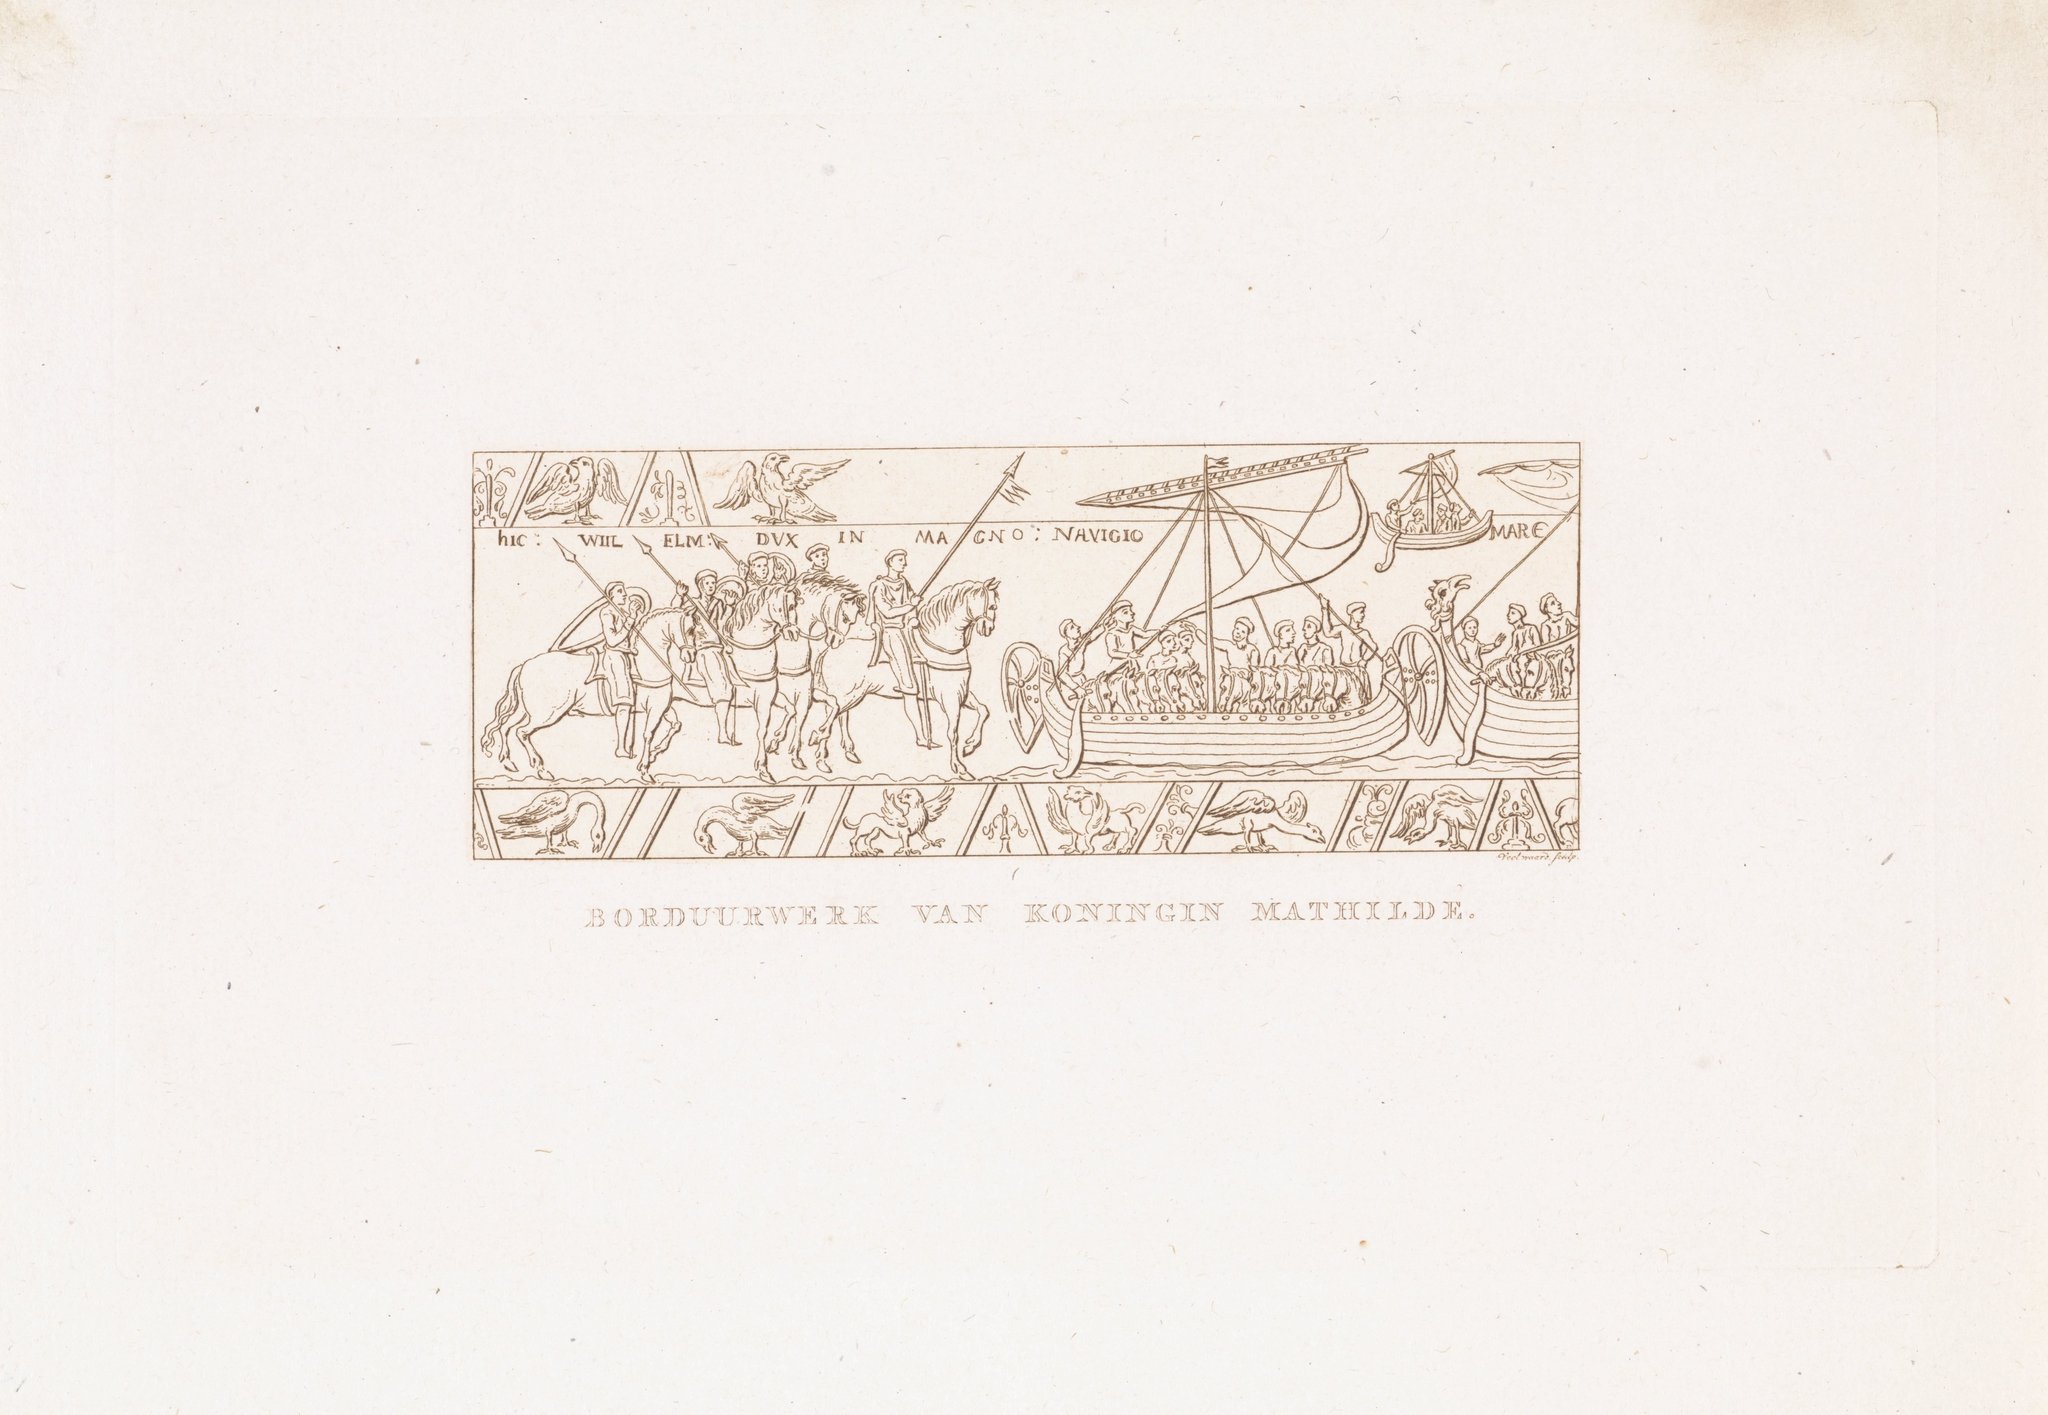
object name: print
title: Borduurwerk van koningin Mathilde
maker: daniël veelwaard (i)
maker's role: print maker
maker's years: 1766-1851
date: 1776-1851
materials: paper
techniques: etching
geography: amsterdam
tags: embroidery (ornamentation)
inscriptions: collector's mark: Lugt 2228